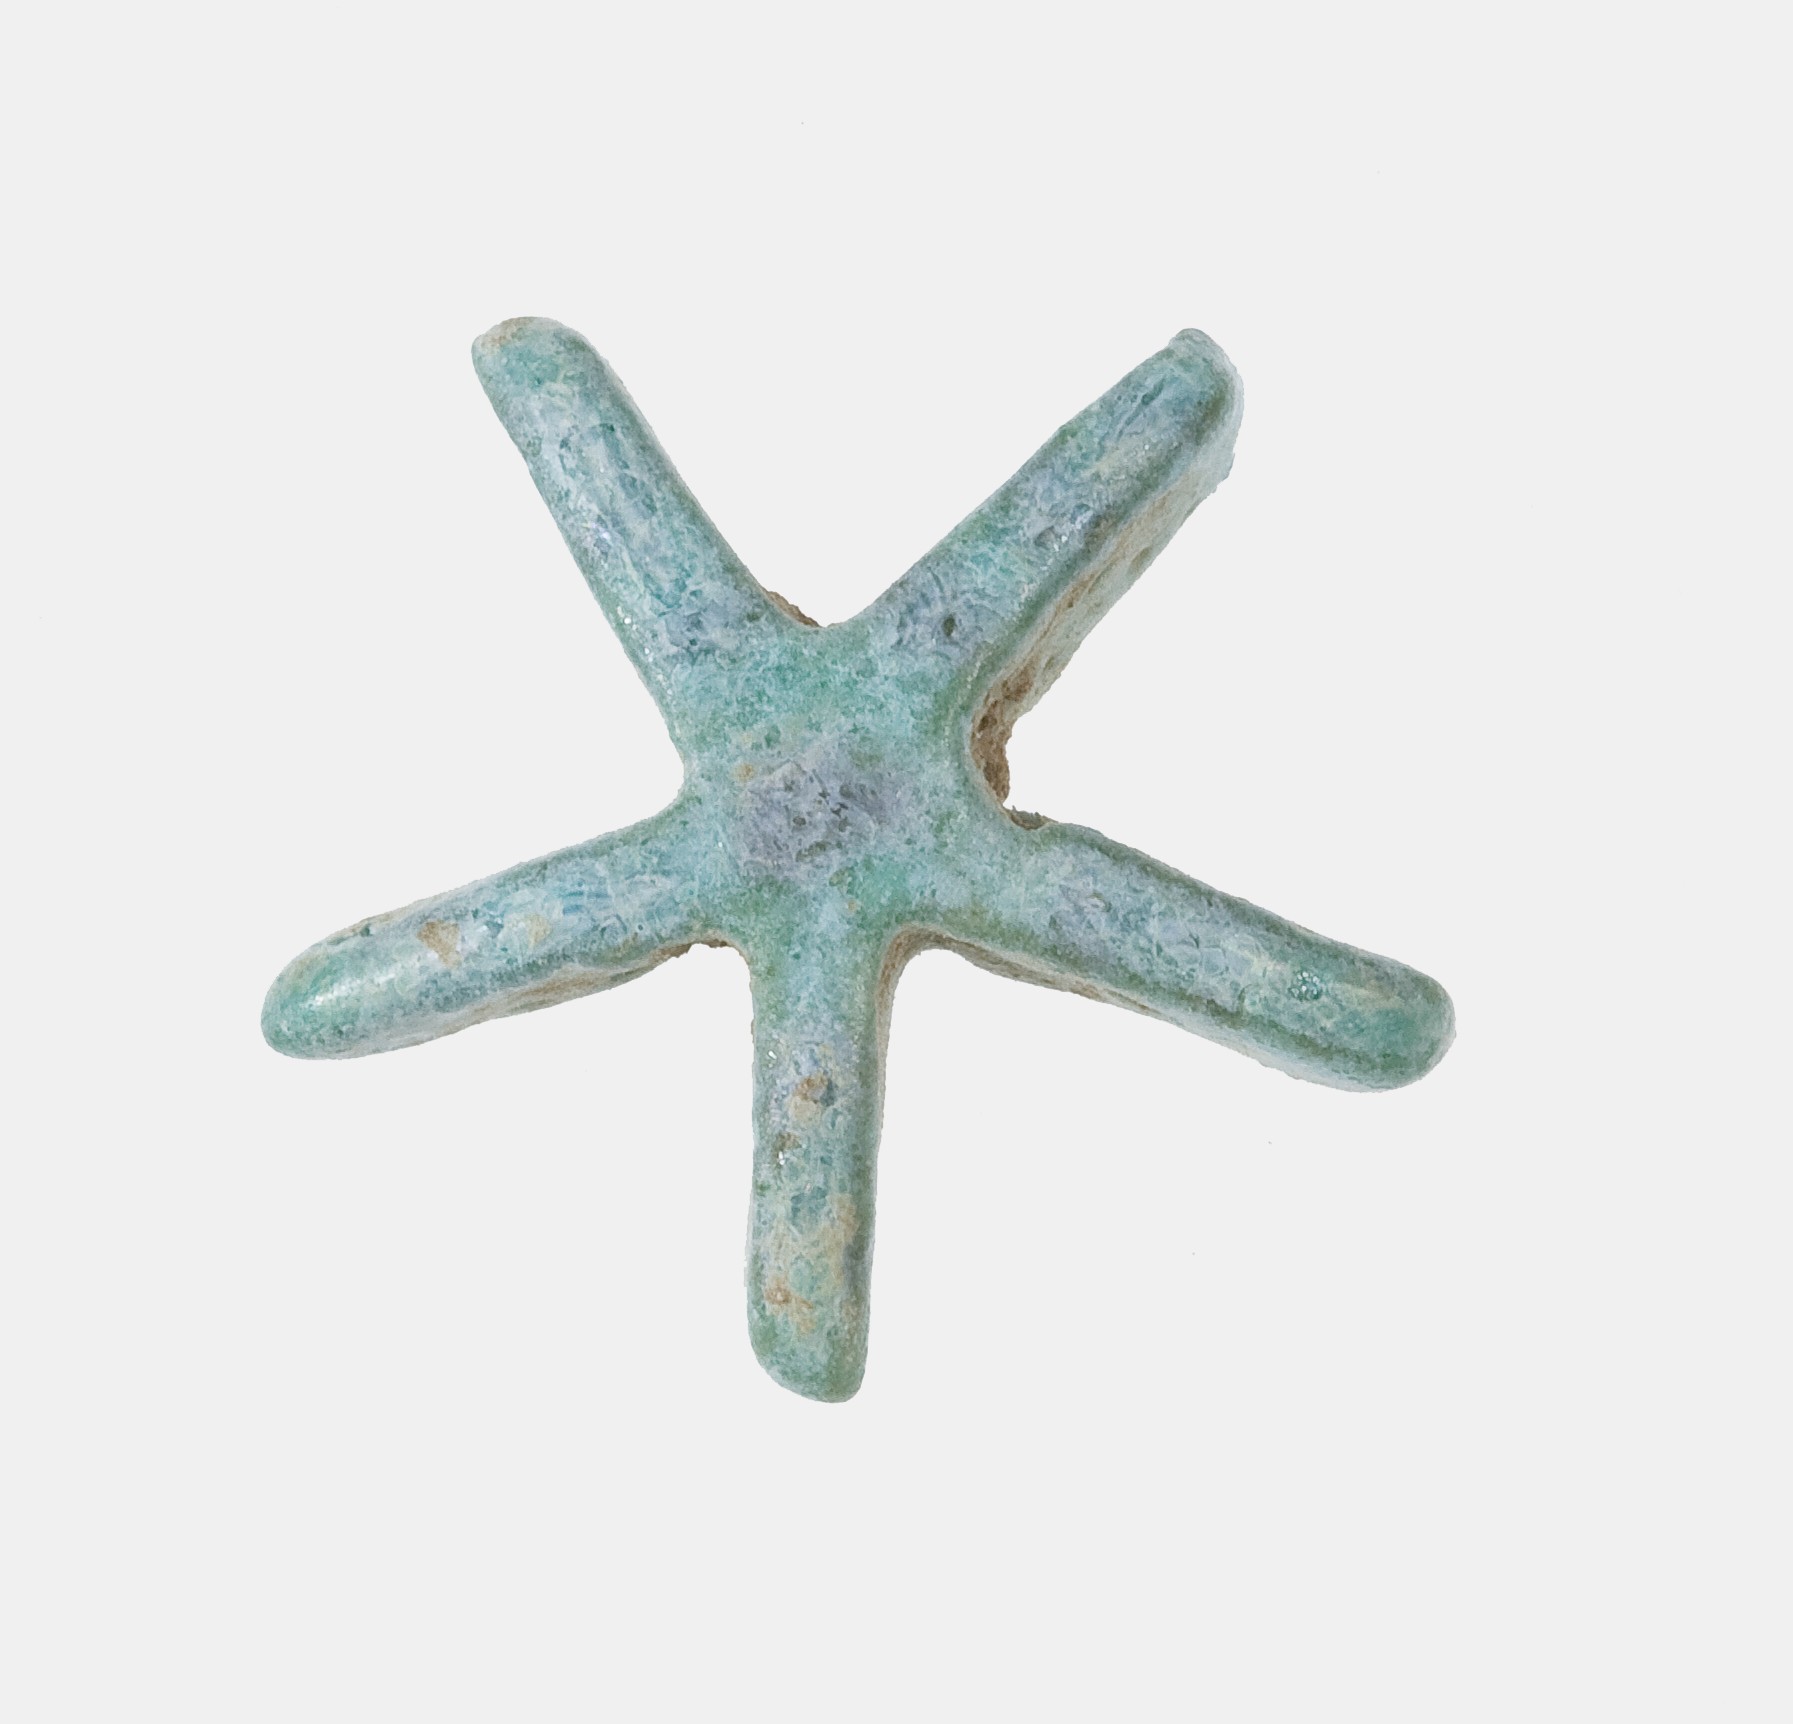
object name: amulet, star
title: Star Amulet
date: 1802-1450 BCE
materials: faience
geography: egypt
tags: stars